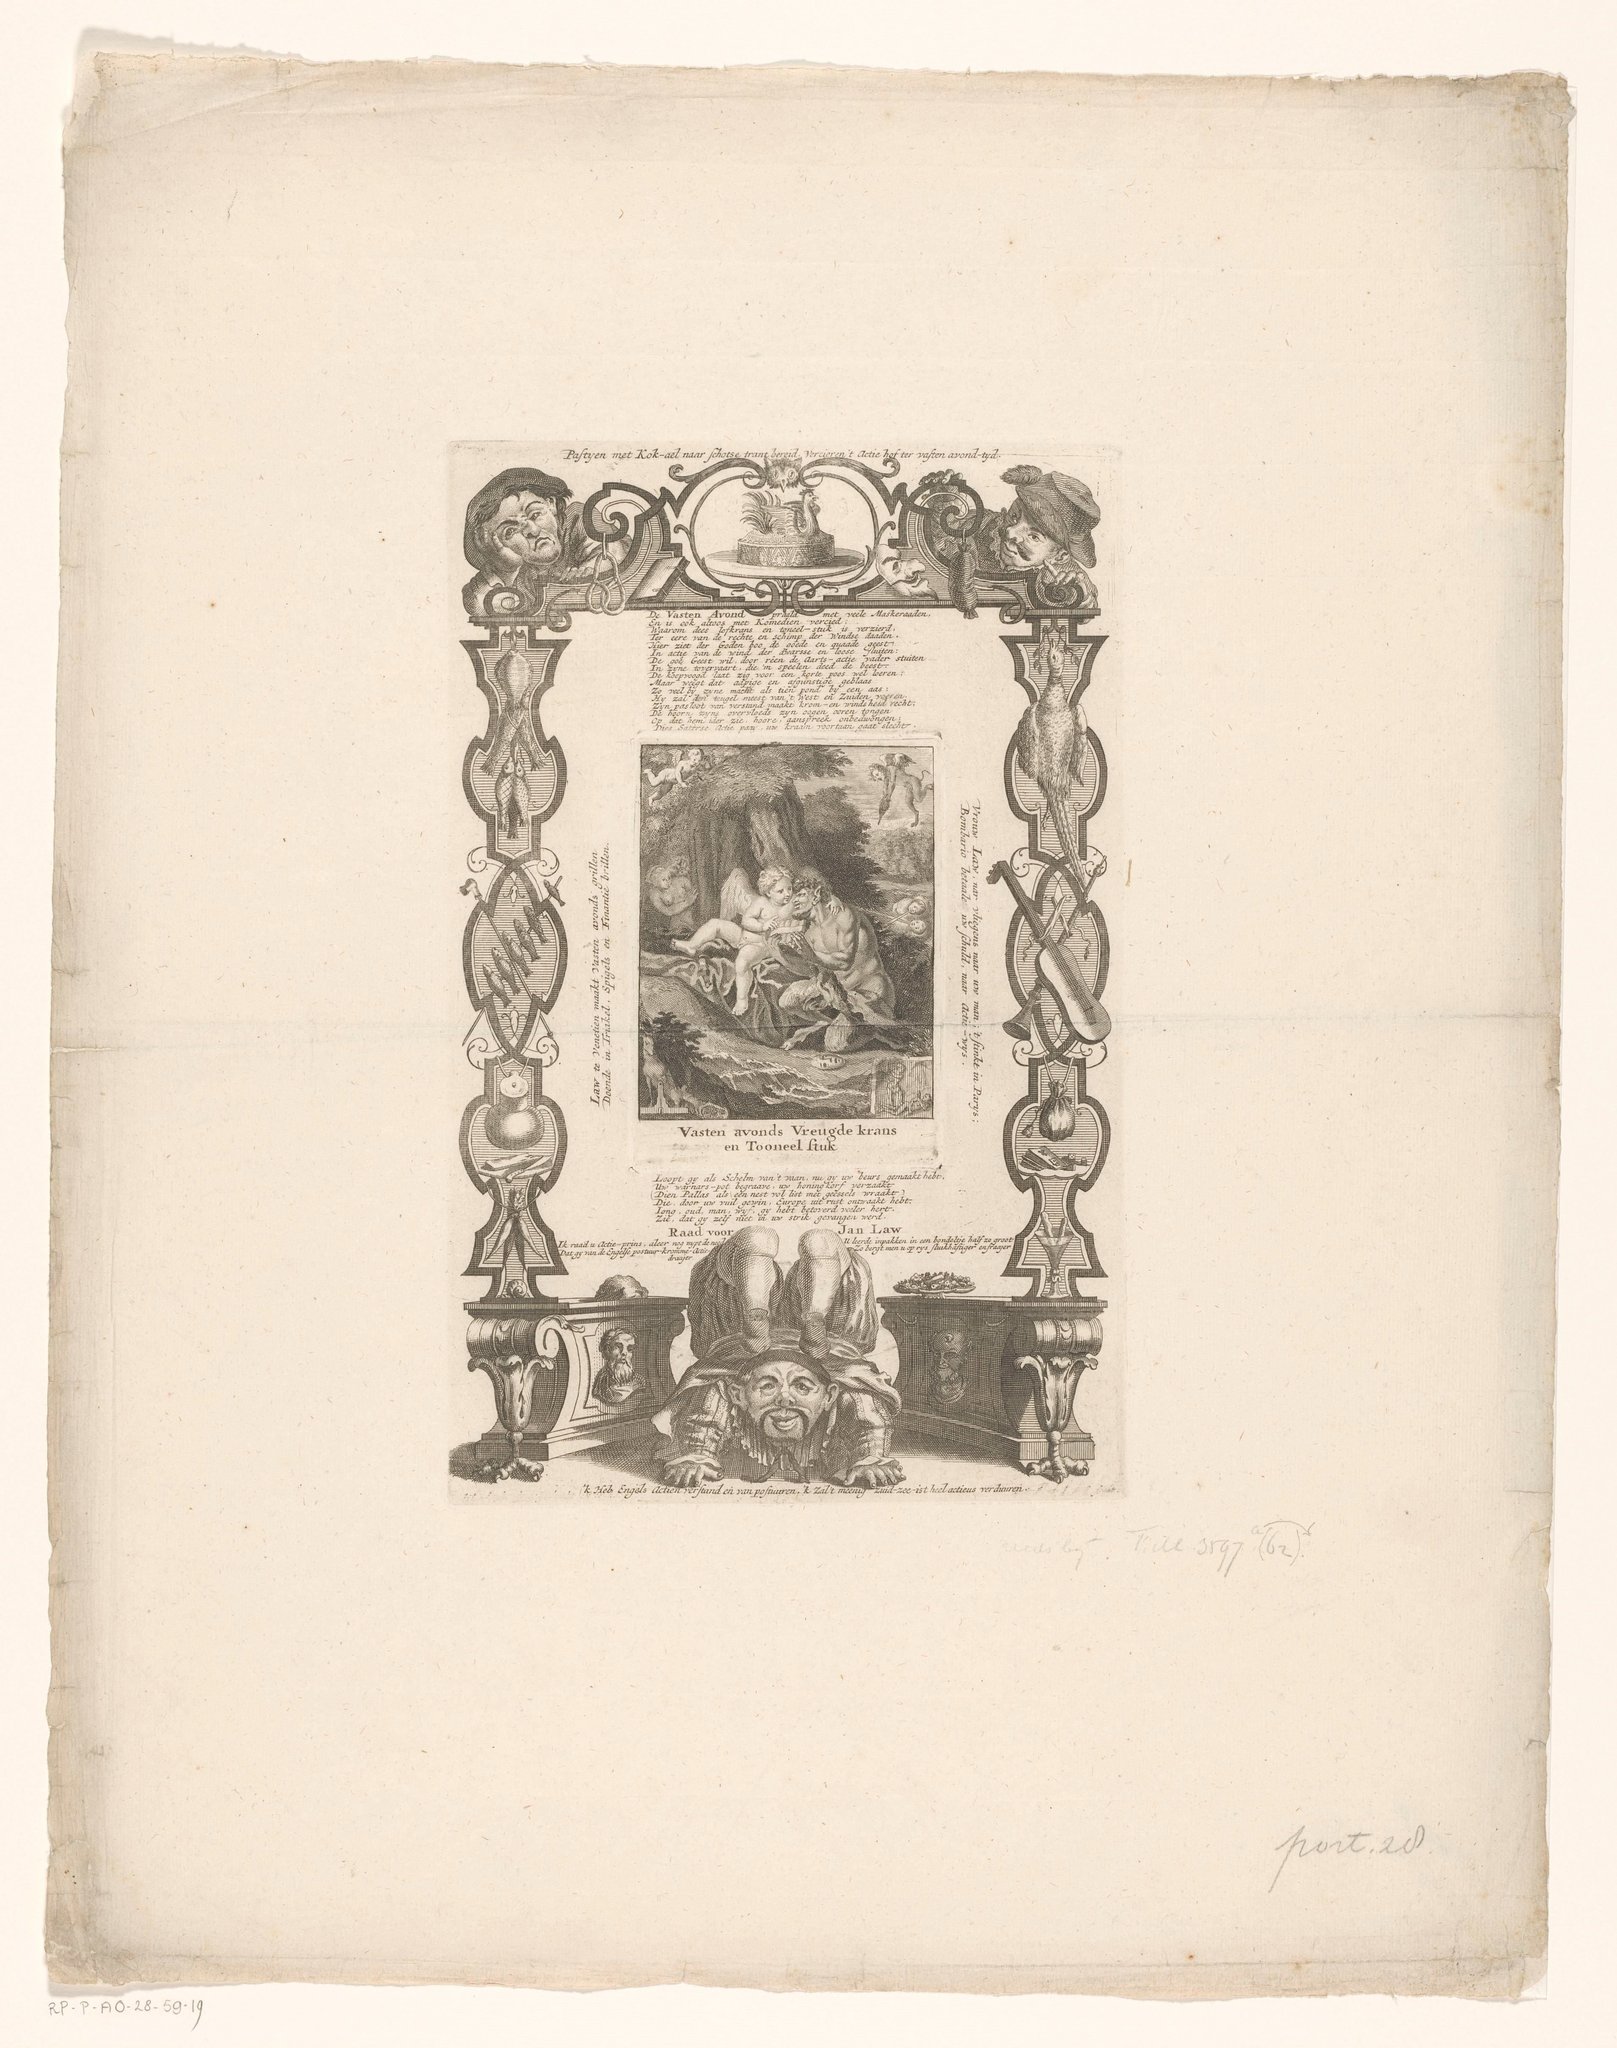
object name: print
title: Vasten avonds vreugde krans en tooneel stuk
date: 1720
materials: paper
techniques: engraving, etching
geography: amsterdam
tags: most important deeds: marsyas and the flute, little people, shrove thursday, 'jeudi gras'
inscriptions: collector's mark: Lugt 2228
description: Prent gebruikt in: Het Groote Tafereel der Dwaasheid, vertoonende de opkomst, voortgang en ondergang der Actie, Bubbel- en Windnegotie, in Vrankrijk, Engeland en de Nederlanden gepleegt in den Jaare 1720 (…). Amsterdam: weduwe Joachim Ottens, 1720. Van deze publicatie zijn verschillende drukken verschenen. De centrale plaat is oorspronkelijk door Jean Audran naar Antoine Coypel (zie FMH 3597/62b). Onderaan de plaat met de omlijsting zijn nog sporen zichtbaar van de weggepolijste namen van de vervaardigers I.C.F[olkema] en I.v.S[assen] en het adres van de uitgever Wilhelmus Koning te Amsterdam. Deze plaat echter niet aangetroffen in het exemplaar van het Dwergentoneel in de Rijksmuseum Research Library van: Il Callotto resuscitato oder Neü eingerichtes Zwerchen Cabinet, Amsterdam: Wilhelmus Koning, 1716.